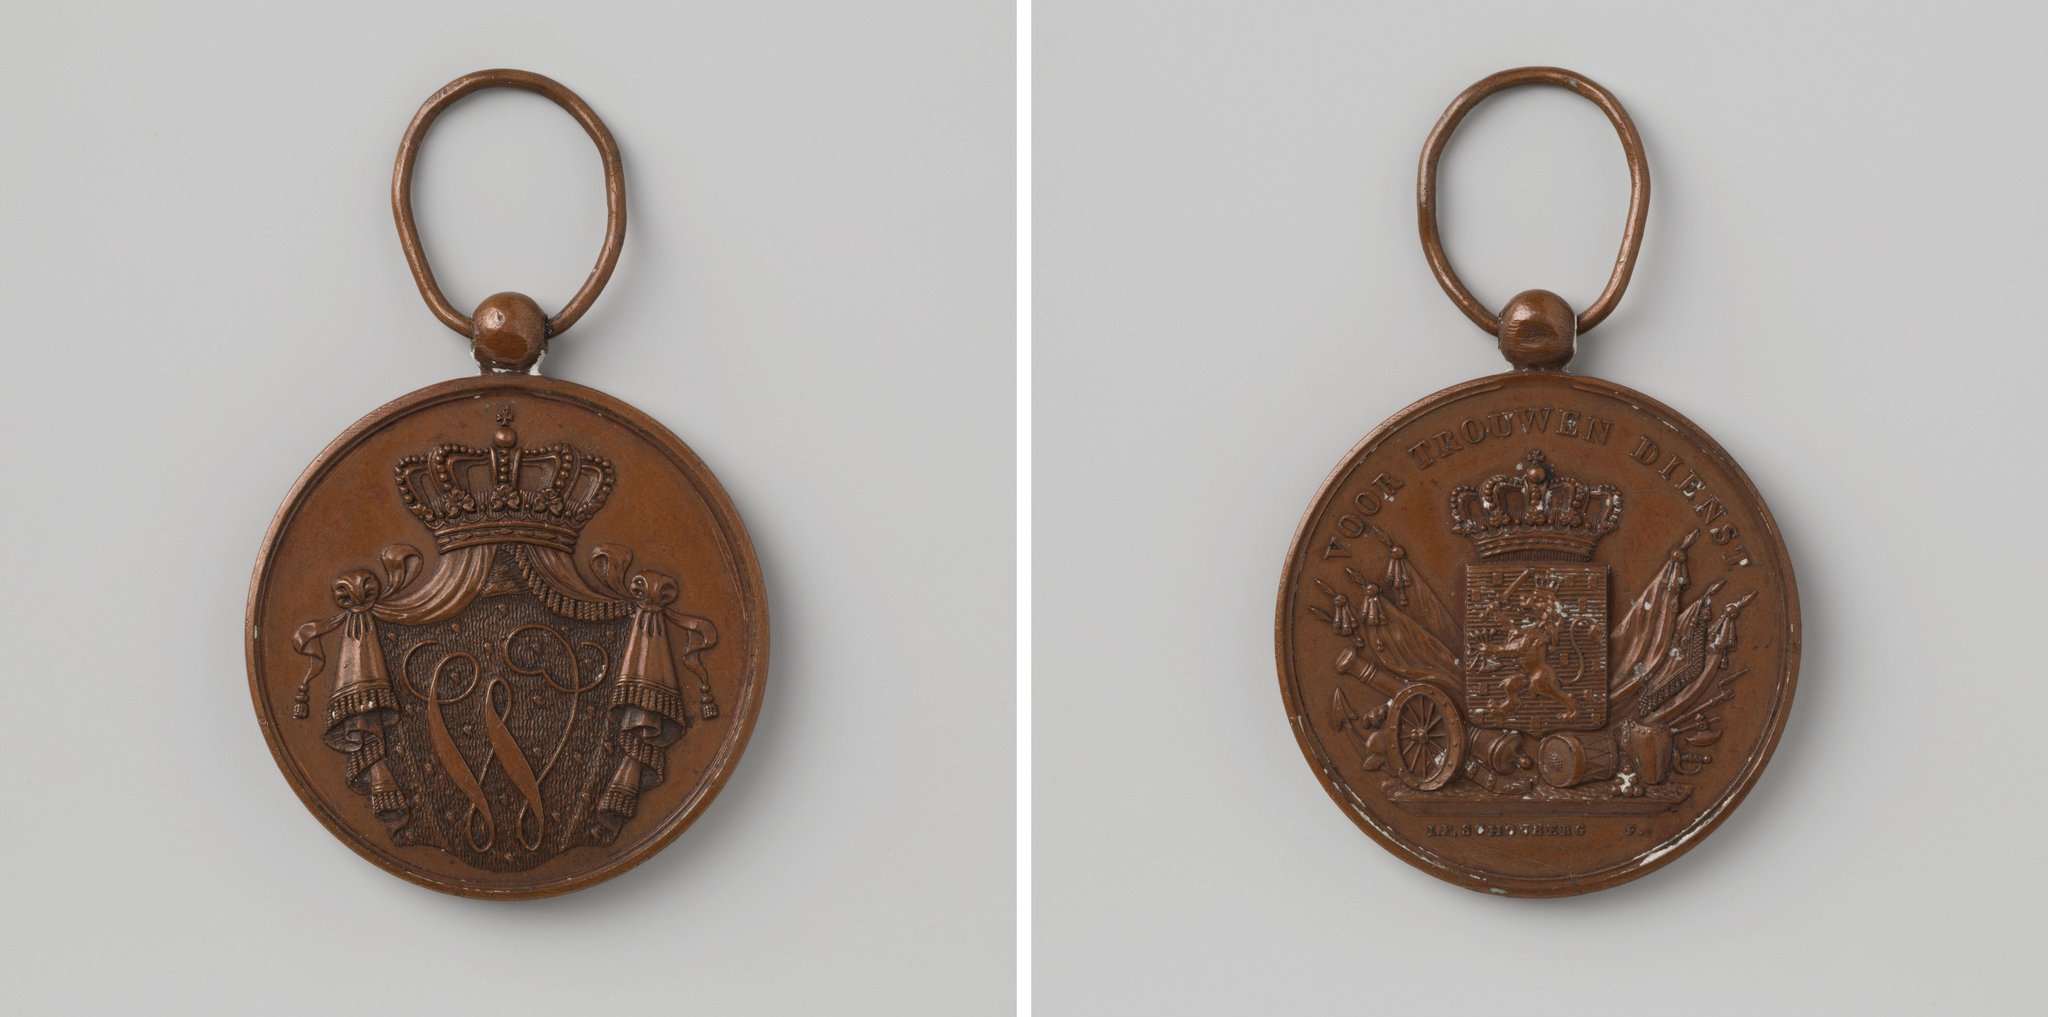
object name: history medal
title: Medaille voor trouwe dienst bij de landmacht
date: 1830-1861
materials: bronze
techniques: striking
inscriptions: signature: ‘I.P. SCHOUBERG F.’, circumscription: ‘VOOR TROUWEN DIENST’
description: Bronzen penning met bal en draagring, op de voorzijde sierletter W op gekroonde mantel, op de keerzijde het gekroonde Nederlandse wapenschild te midden van militaire attributen, met omschrift.